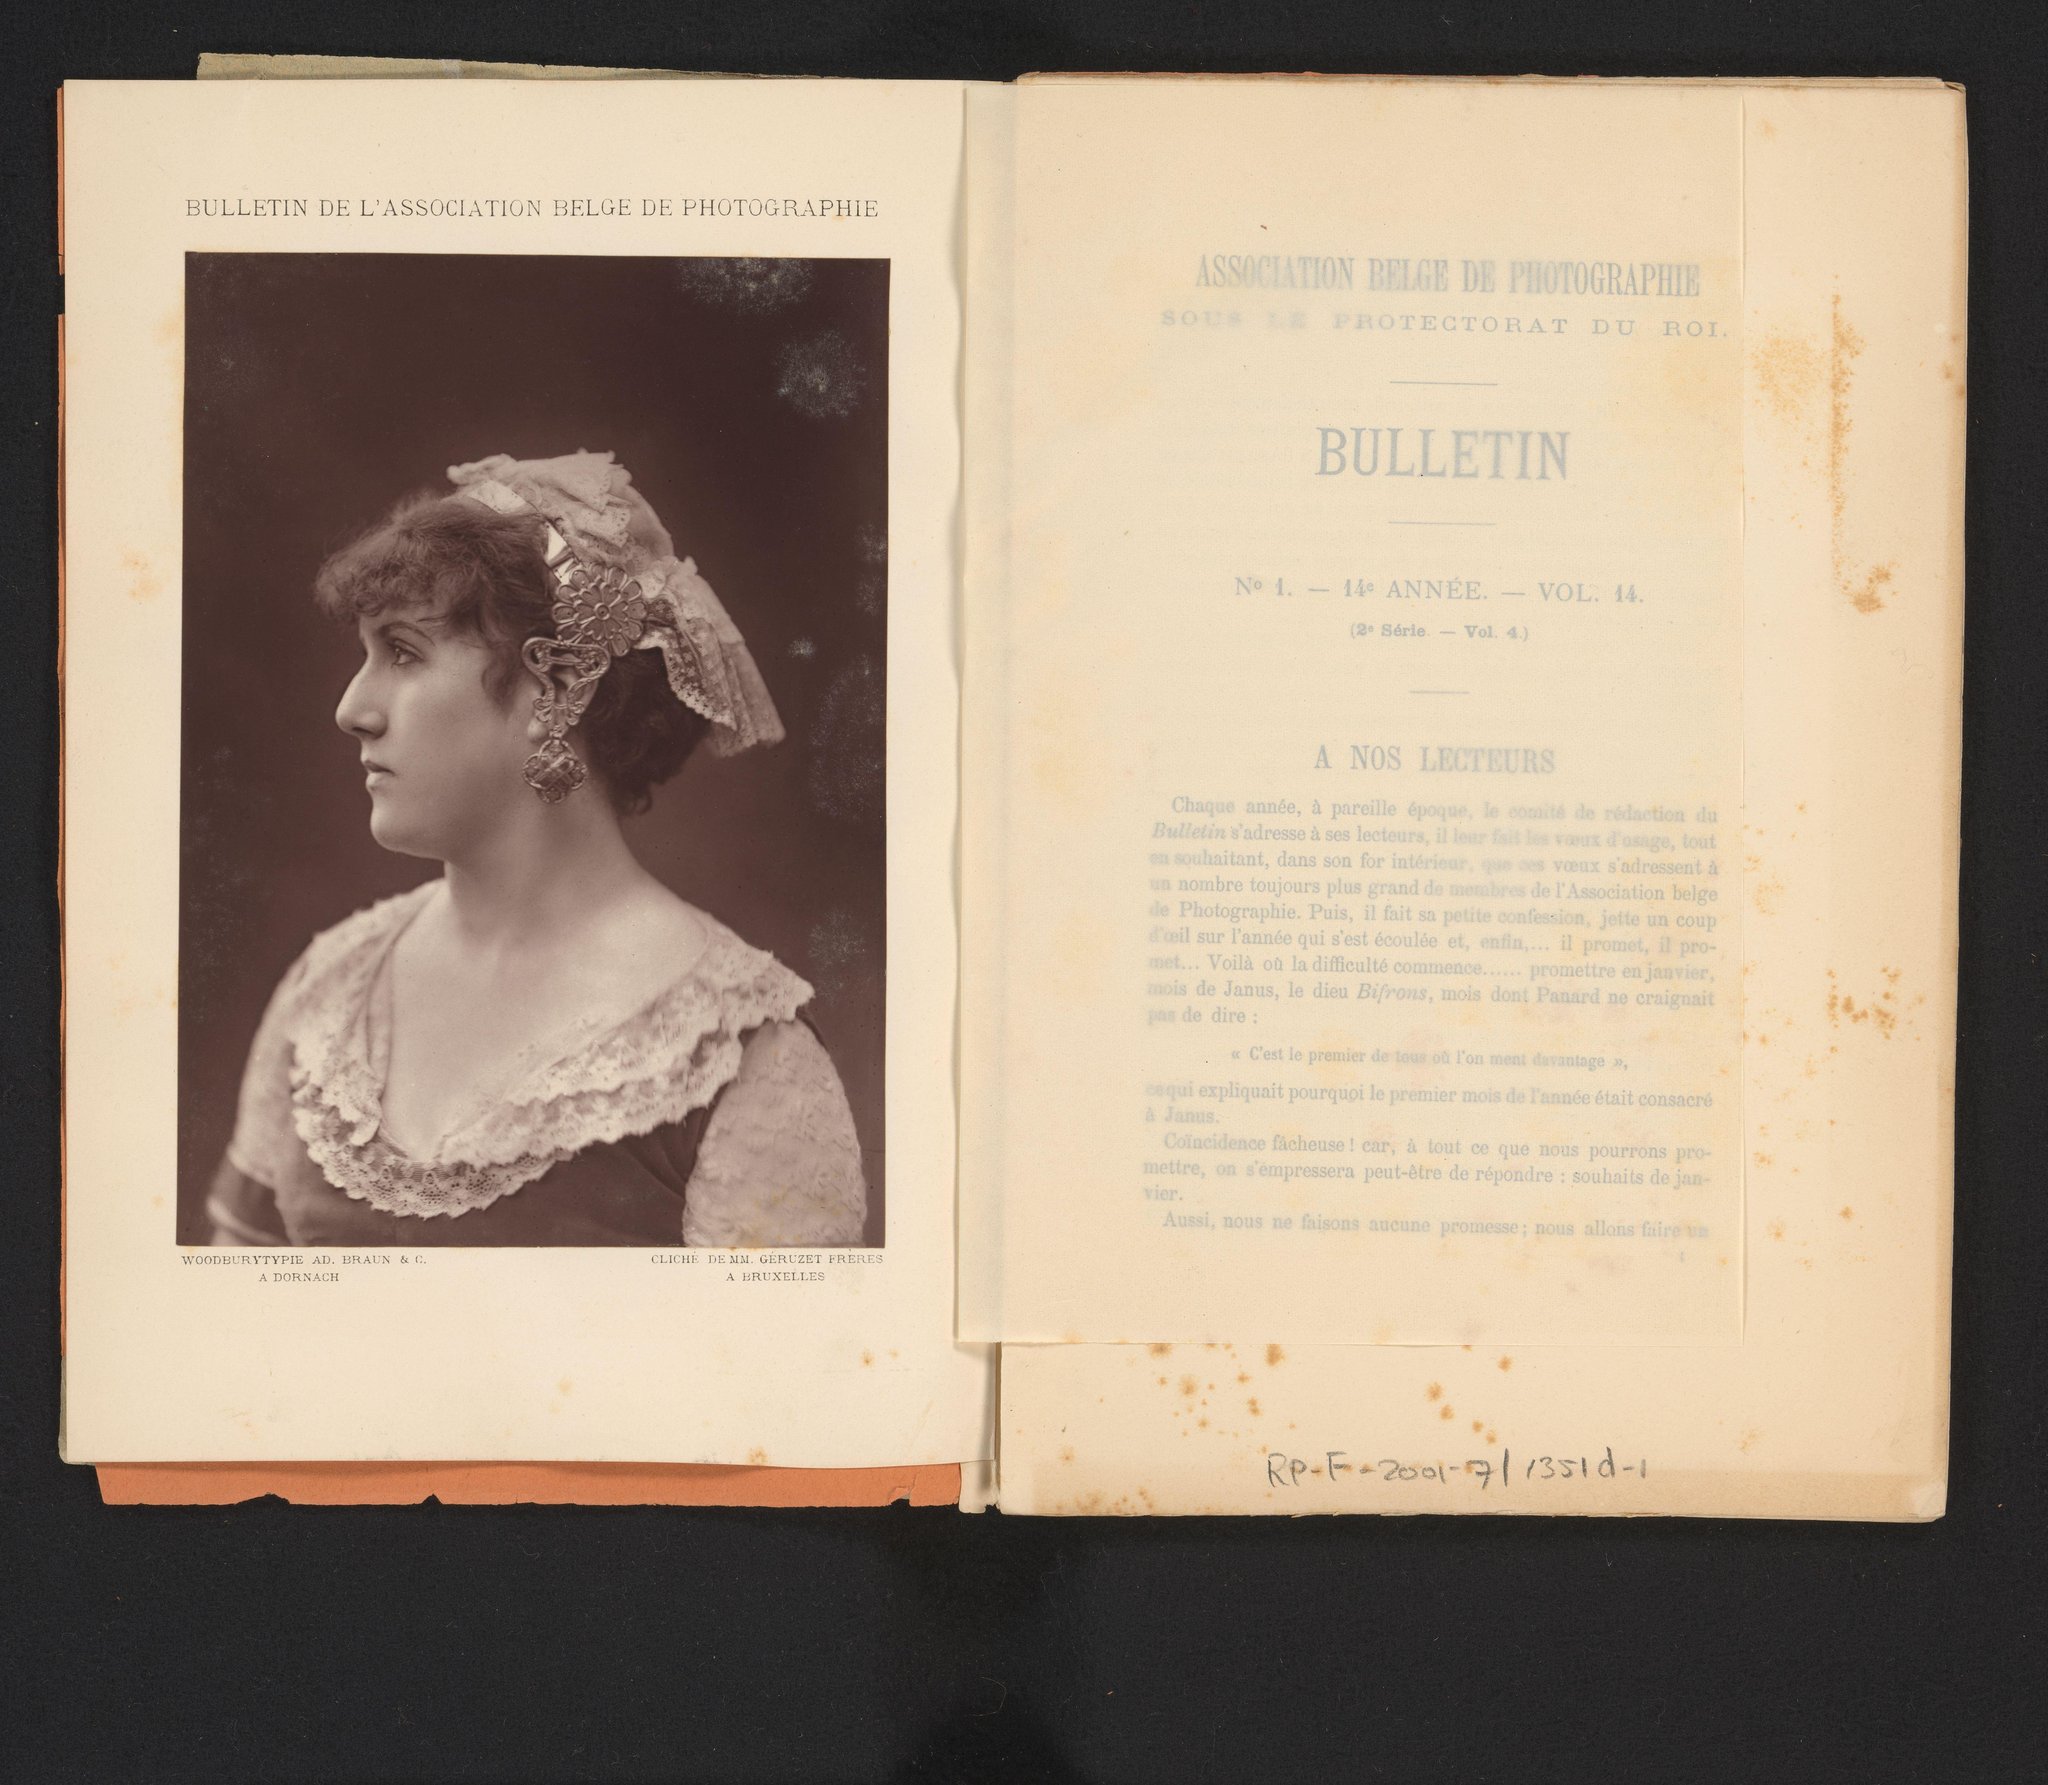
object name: photomechanical print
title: Portret van een onbekende vrouw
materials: paper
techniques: woodburytype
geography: dornach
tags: historical persons not known by name - bb - woman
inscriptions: inscription: ‘BULLETIN DE L'ASSOCIATION BELGE DE PHOTOGRAPHIE’